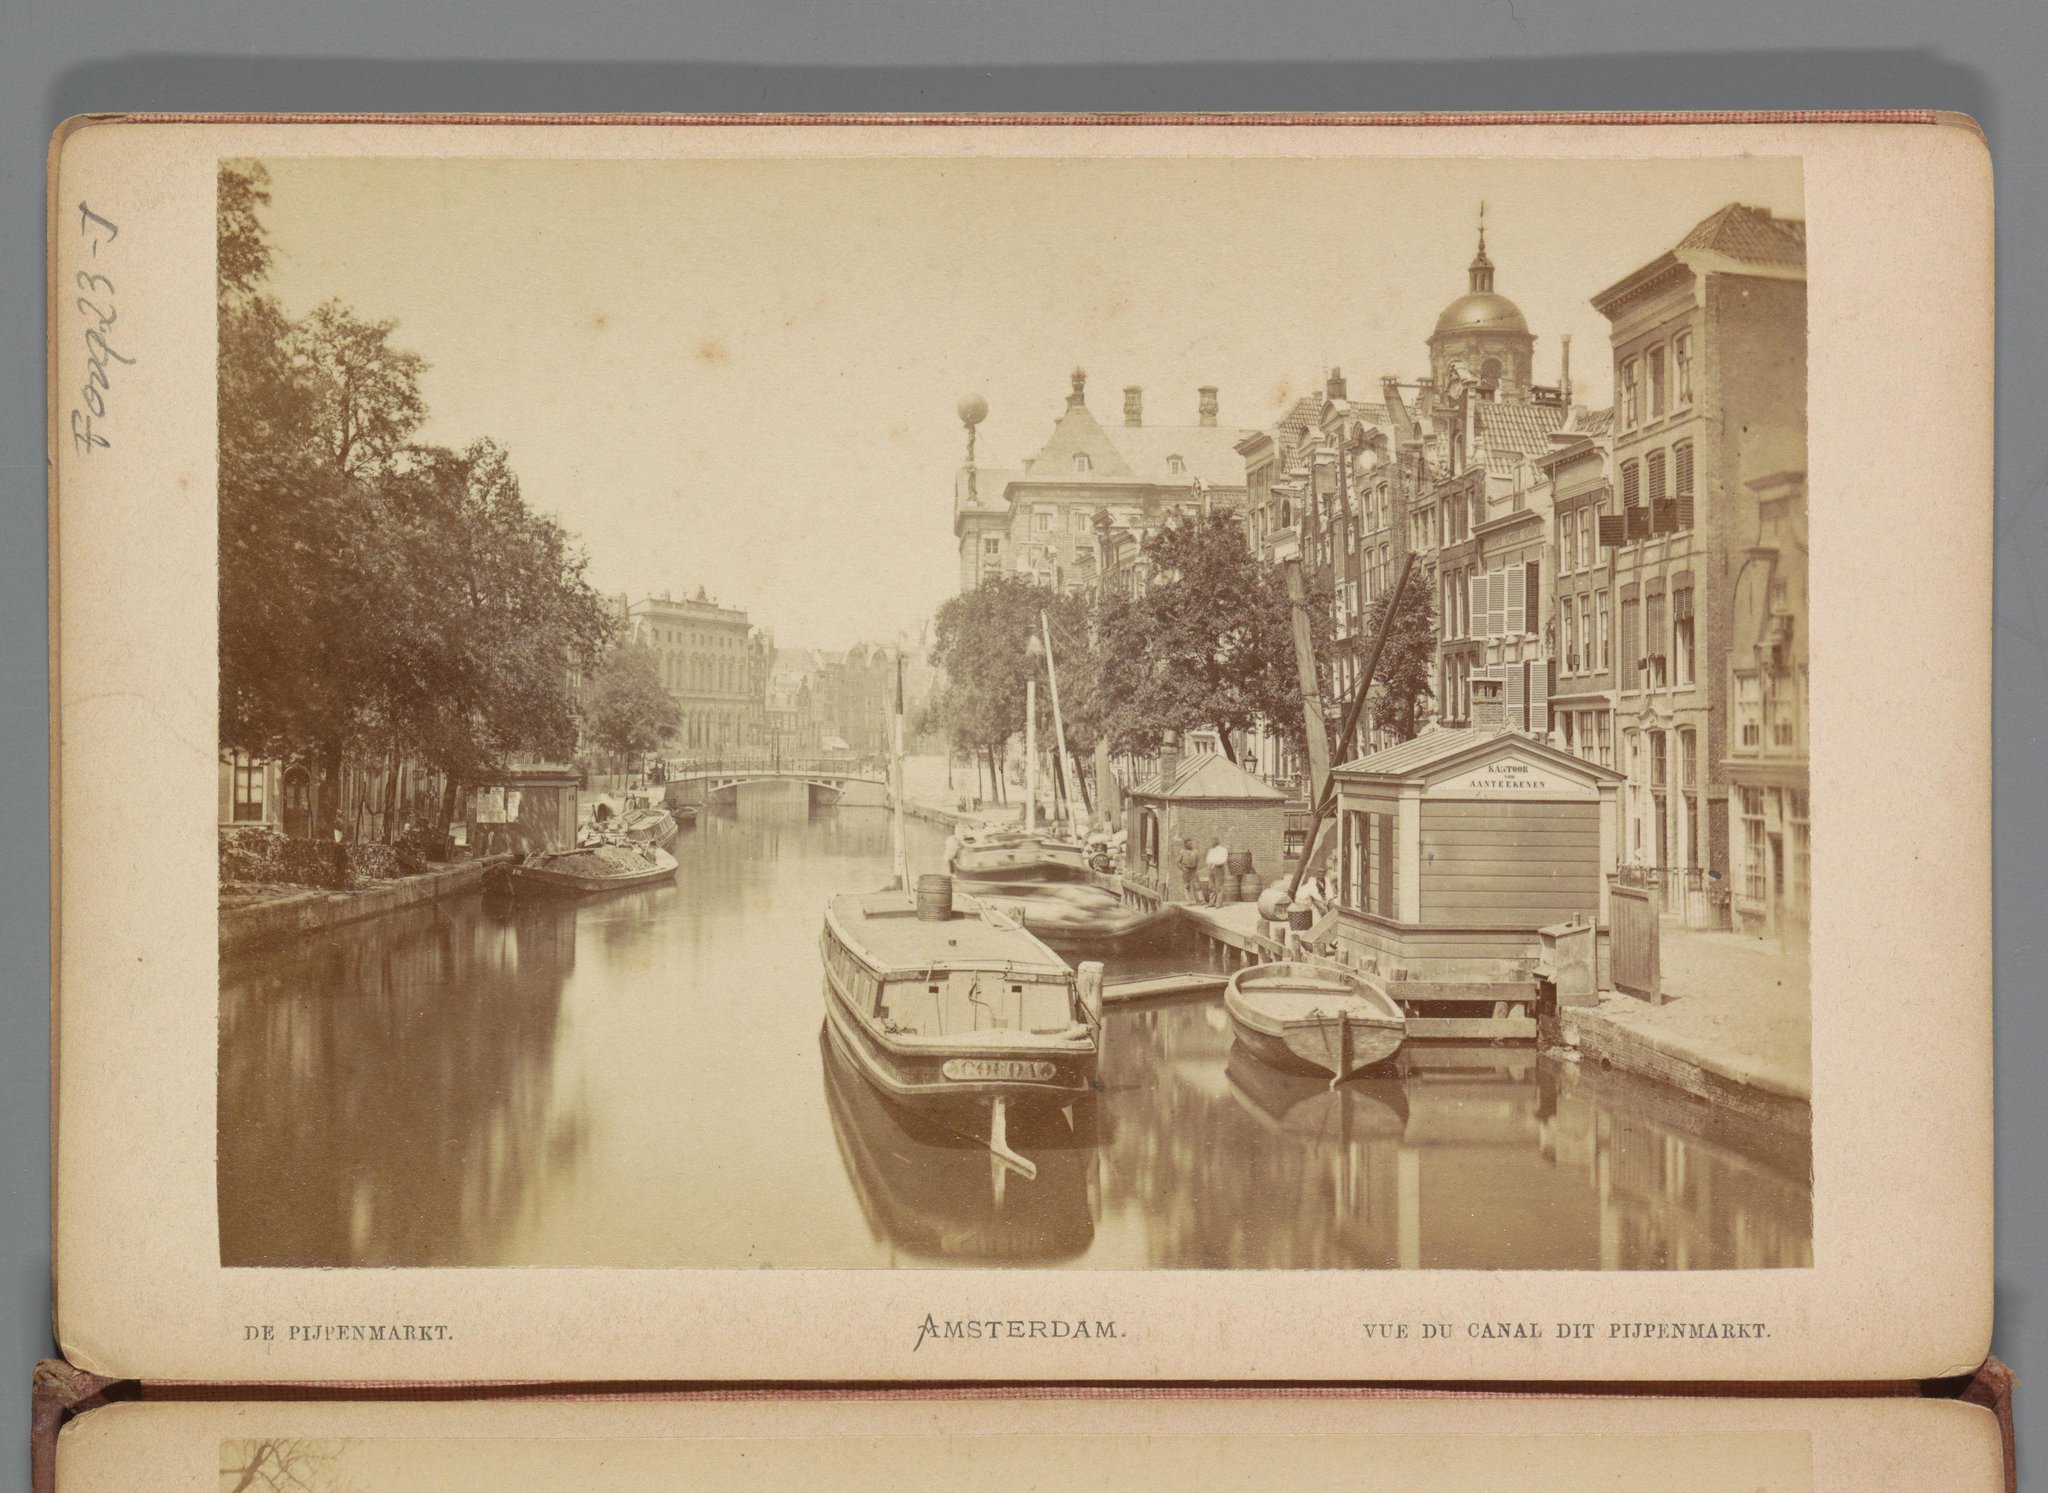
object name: cabinet photograph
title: De Pijpenmarkt. Amsterdam. Vue du canal dit Pijpenmarkt.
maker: andries jager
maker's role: publisher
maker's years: 1825-1905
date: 1860-1884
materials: cardboard, photographic support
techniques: albumen print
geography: amsterdam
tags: sailing-ship, sailing-boat, canals, waters (in city), prospect of city, town panorama, silhouette of city, amsterdam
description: Onderdeel van Leporelloalbum met twaalf foto's van Amsterdam.